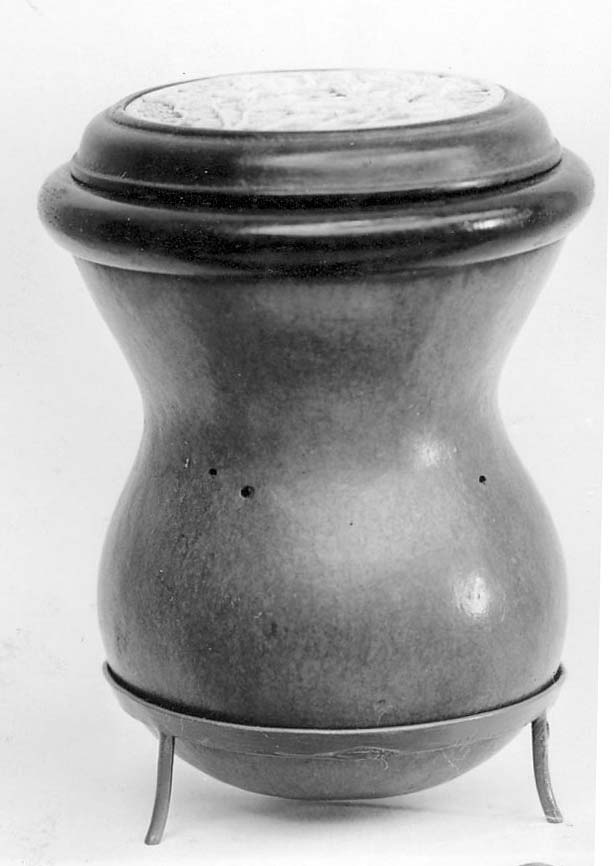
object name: cricket cage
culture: chinese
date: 1701-1900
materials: ivory, wood